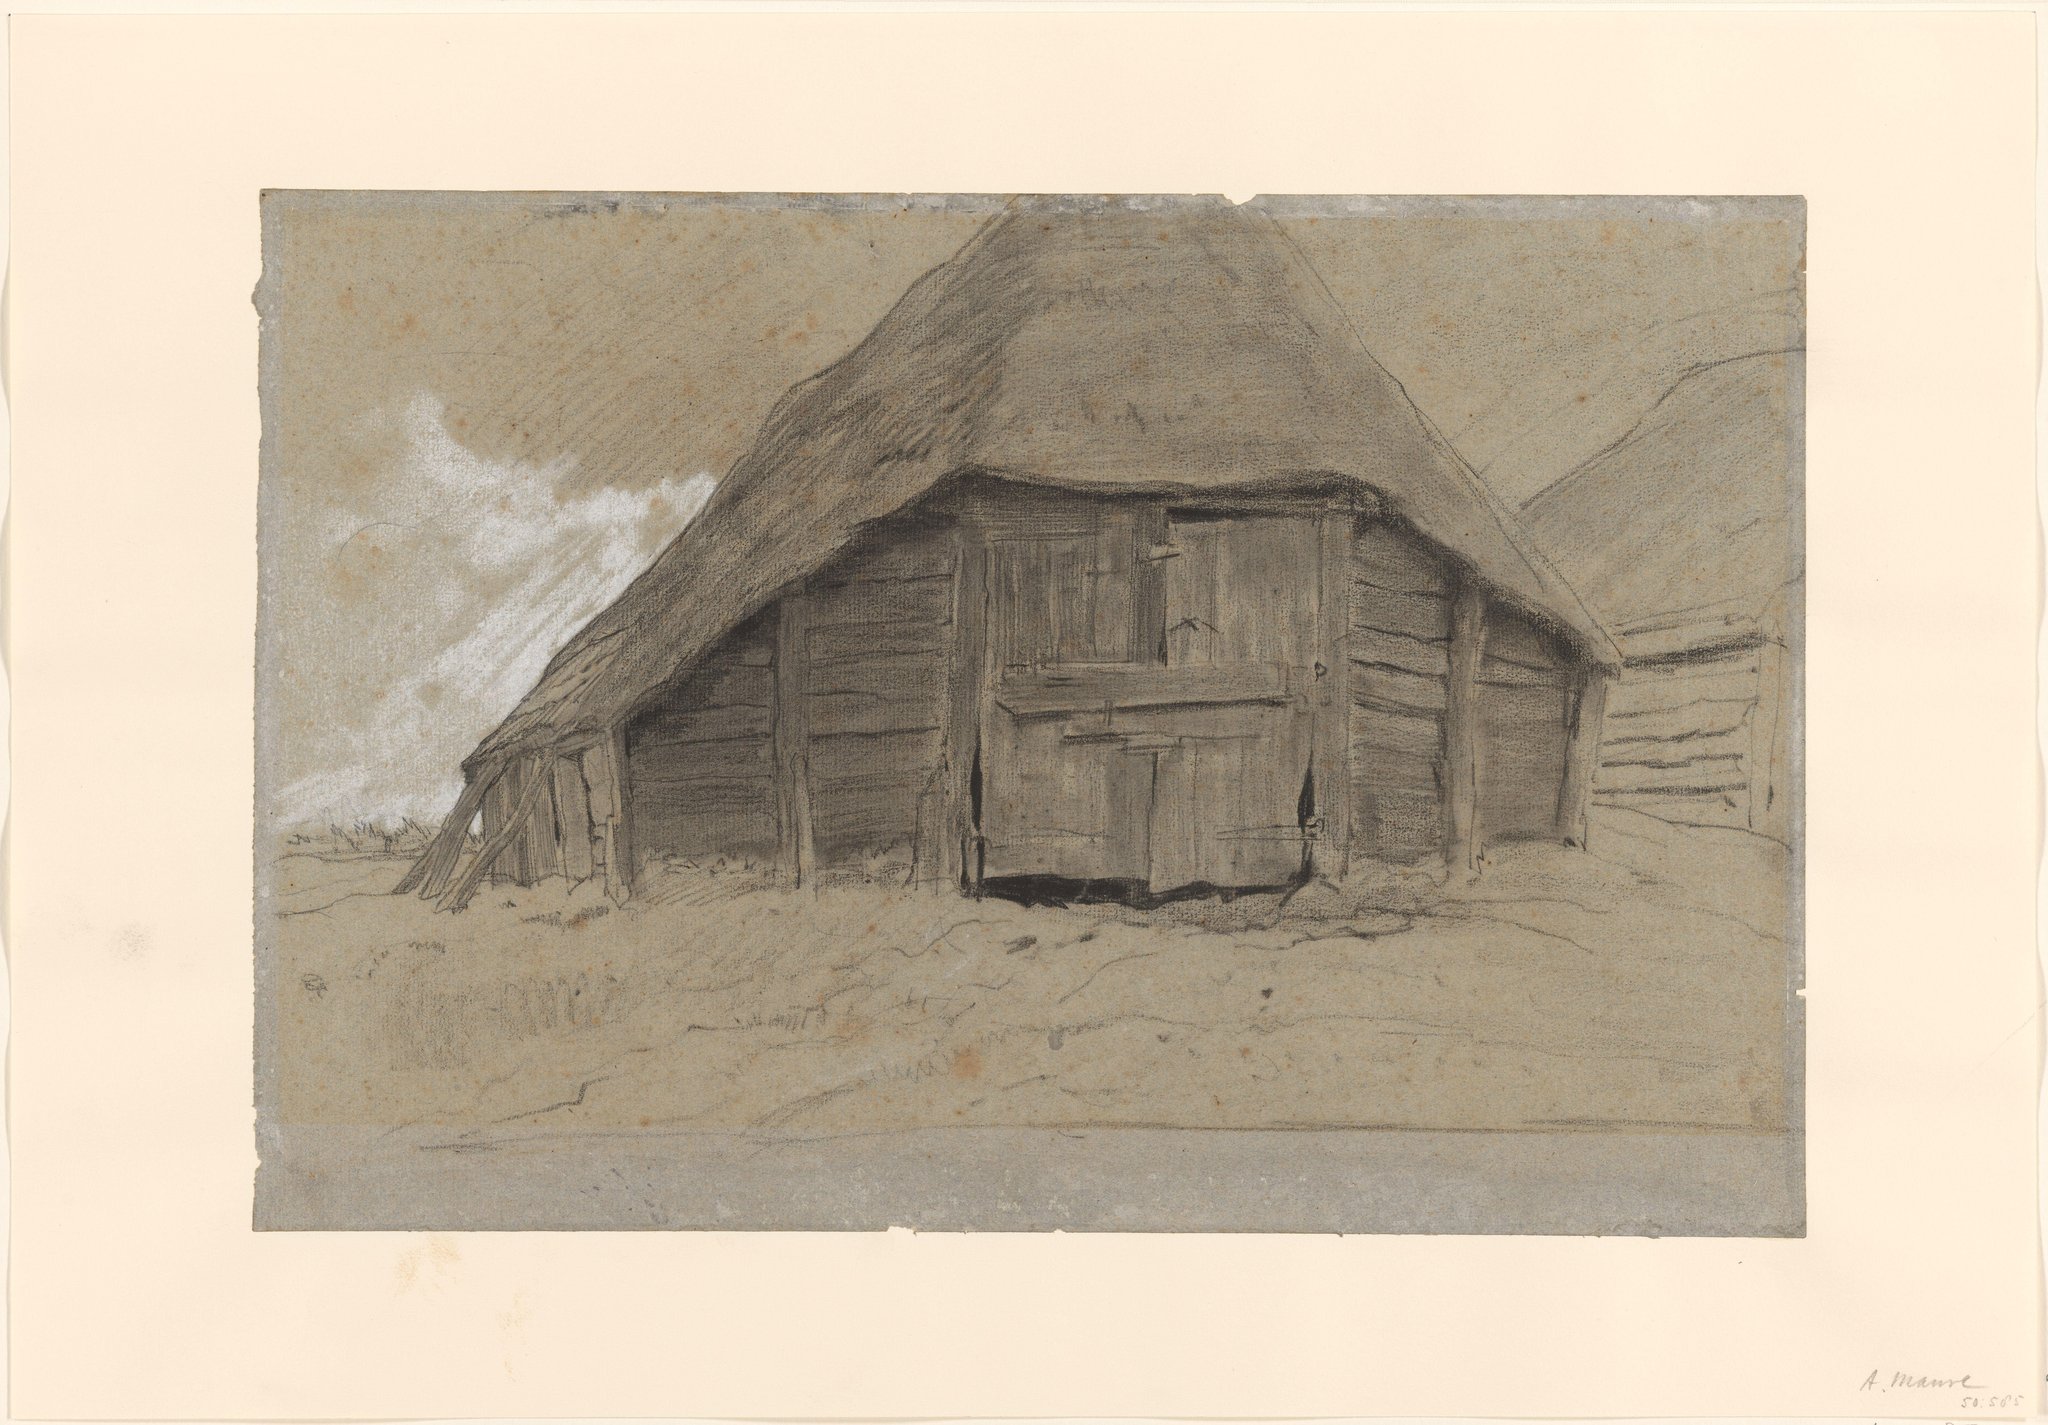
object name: drawing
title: Schaapskooi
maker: anton mauve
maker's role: draughtsman, painter, print maker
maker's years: 1838-1888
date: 1848-1888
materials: chalk, paper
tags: barn